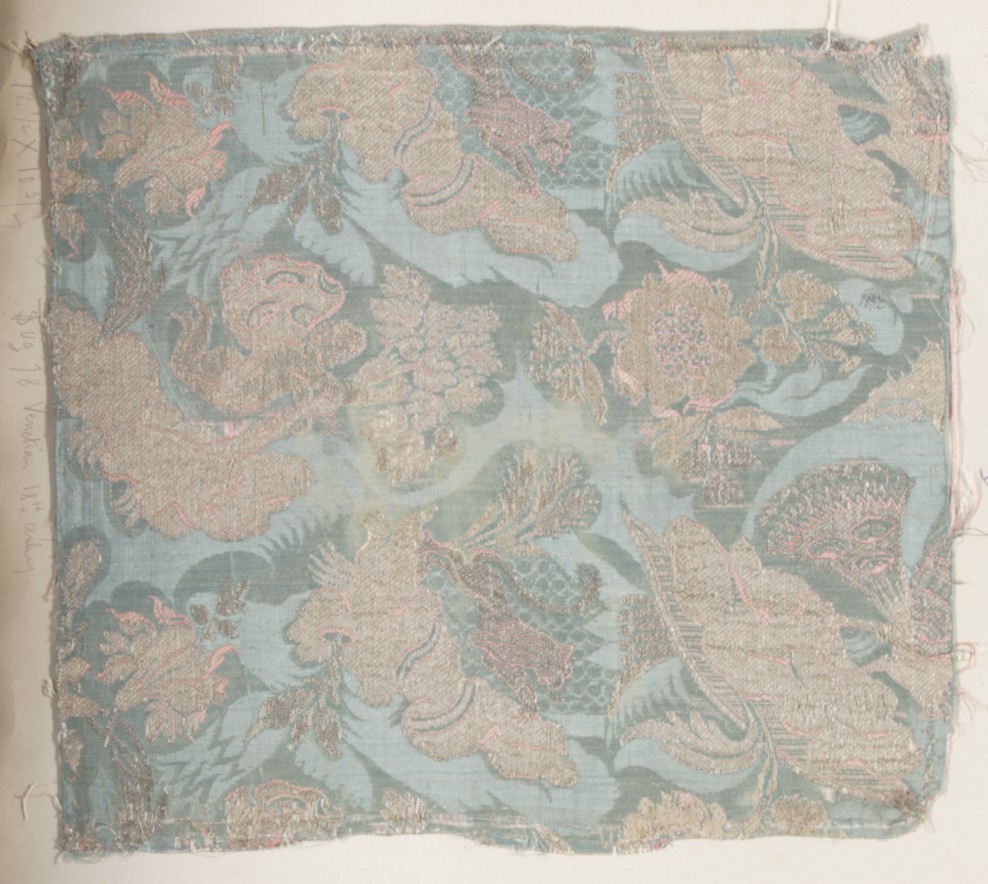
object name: fragment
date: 1701-1800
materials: metal thread, silk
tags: flowers,leaves